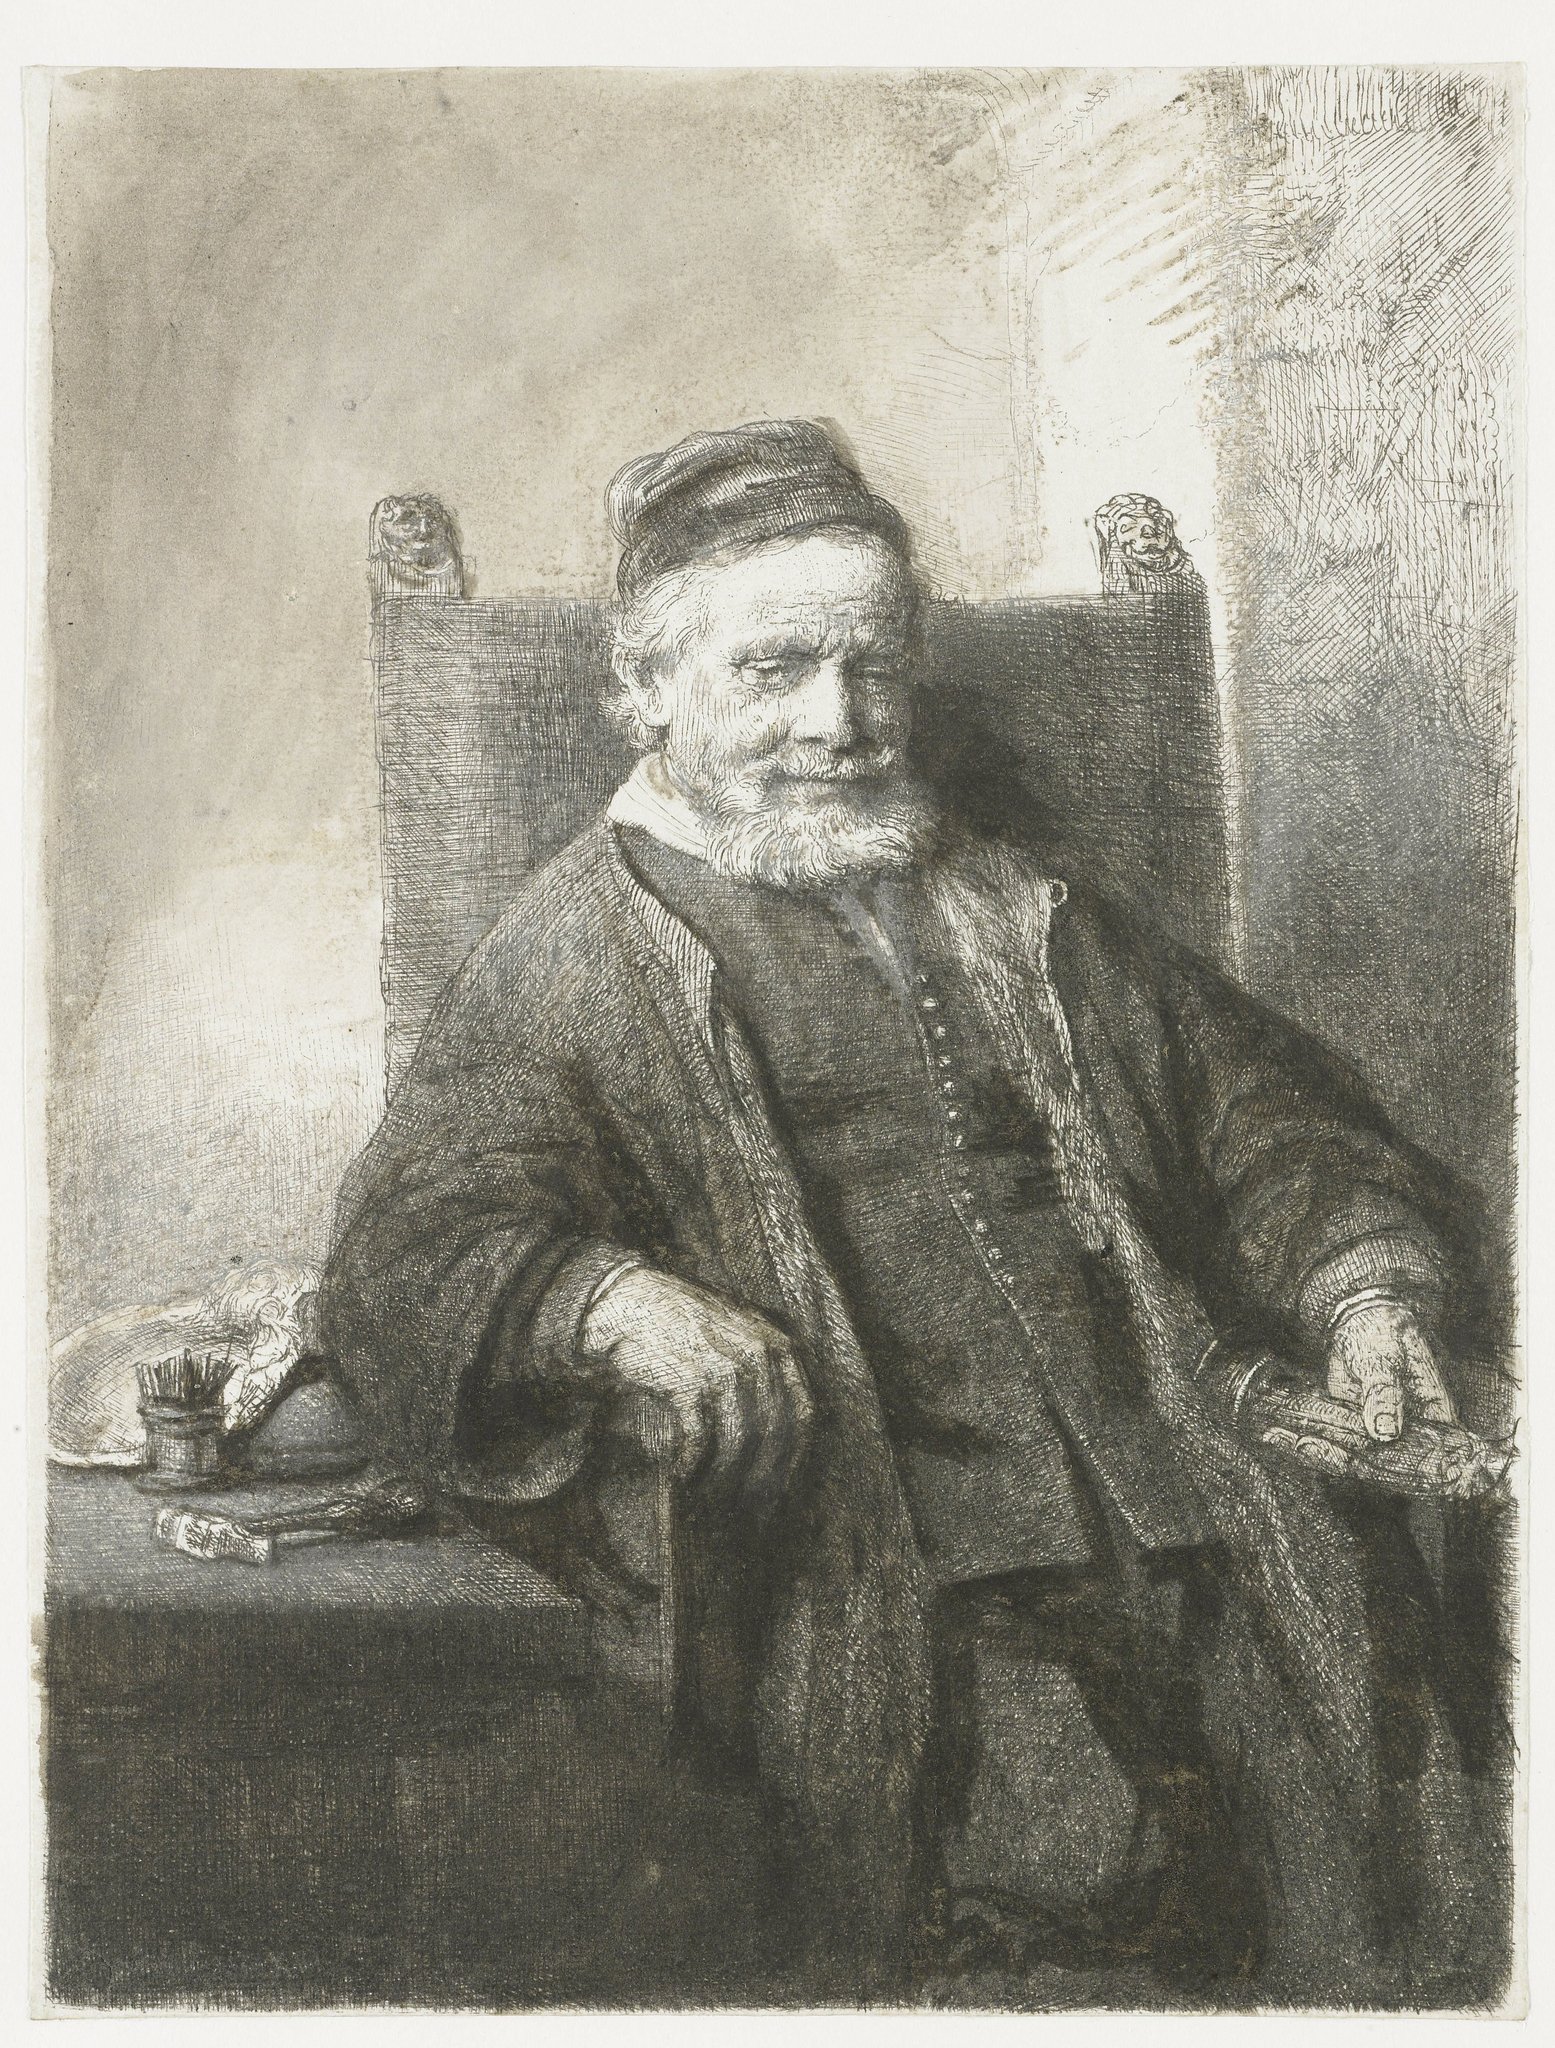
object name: print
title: Jan Lutma, goldsmith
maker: rembrandt van rijn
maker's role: draughtsman, painter, print maker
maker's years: 1606-1669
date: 1656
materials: paper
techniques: brush, printmaking, drypoint, etching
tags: silversmith, johannes lutma (1584-1669)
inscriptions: collector's mark: Lugt 240